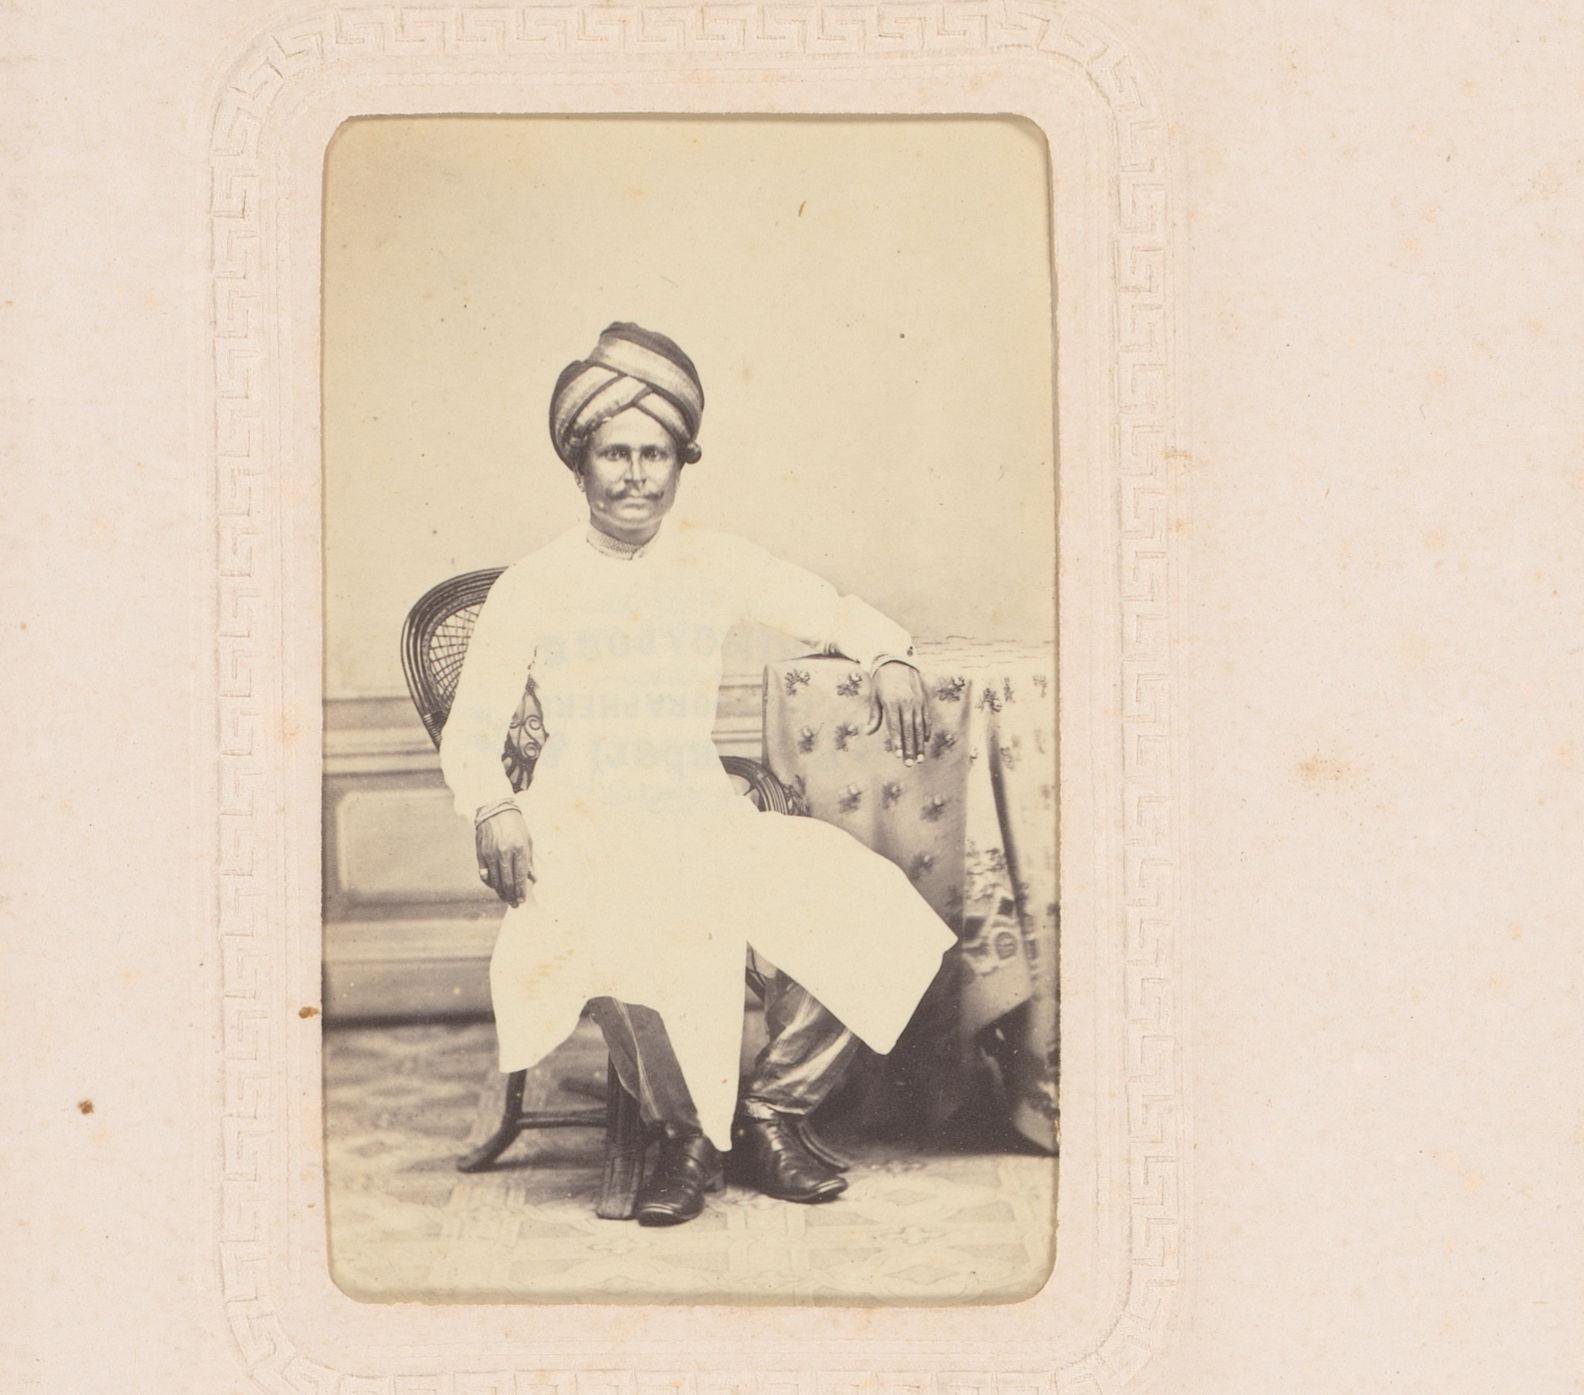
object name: album leaf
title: Portret van een Indiase man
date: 1870-1880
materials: cardboard, photographic support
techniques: albumen print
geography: singapore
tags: historical persons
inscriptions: number: ‘49’, annotation: ‘1 Bengal: [...] court’